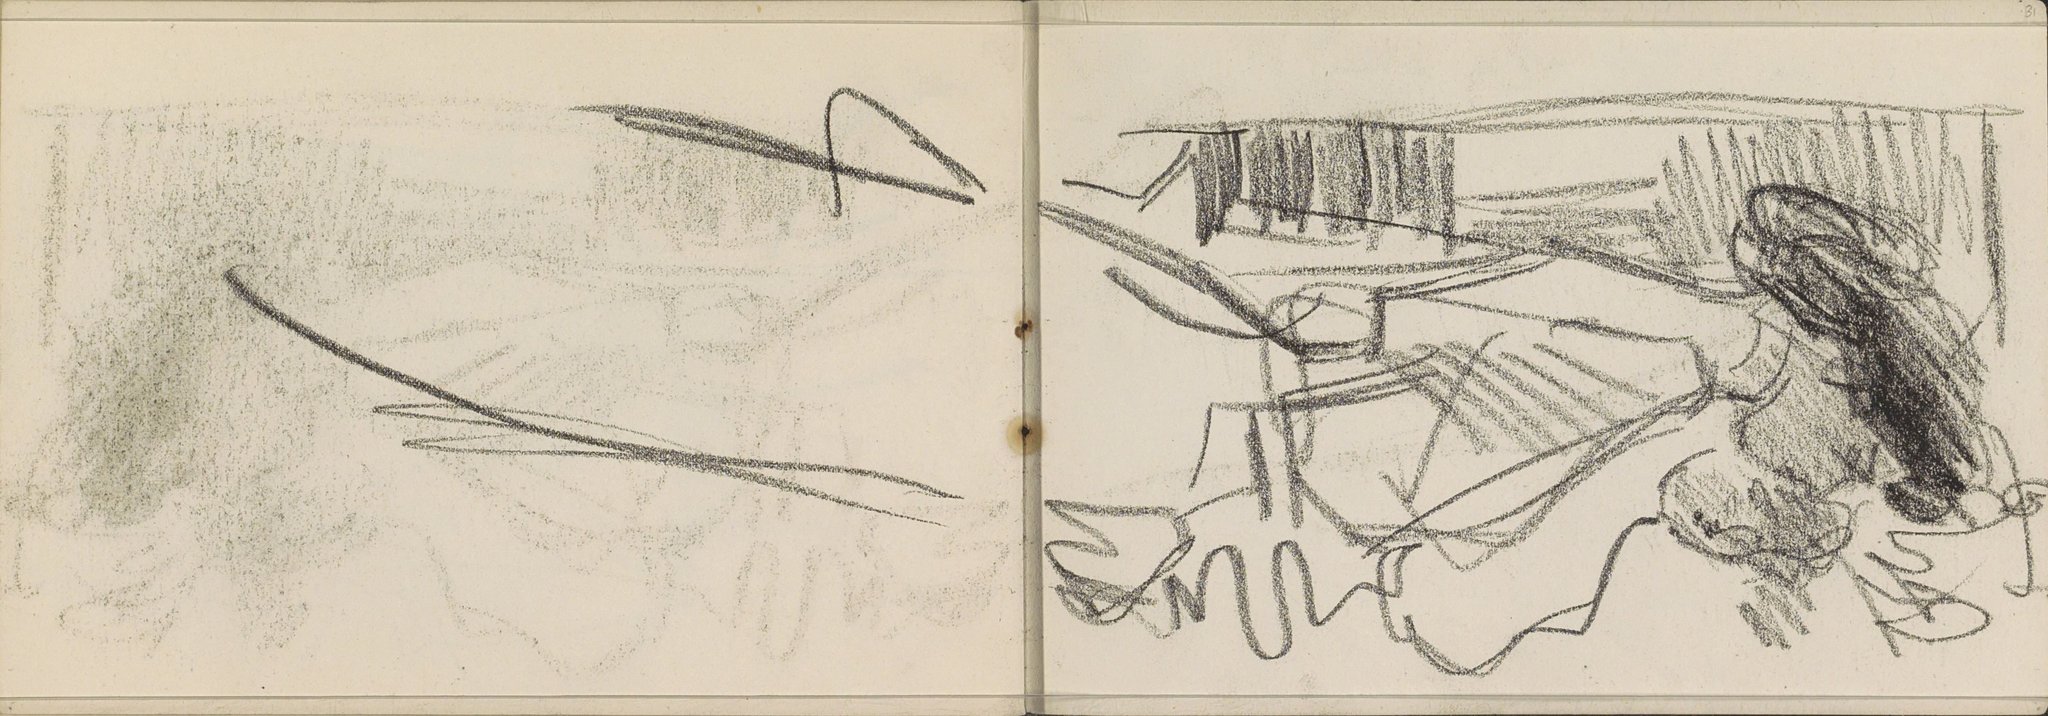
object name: sketchbook leaf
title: Twee staande vrouwen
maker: isaac israels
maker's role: draughtsman, painter, print maker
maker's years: 1865-1934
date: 1875-1934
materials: chalk, paper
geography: the hague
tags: adult woman (+ standing)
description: Pagina 30 en pagina 31 uit schetsboek XLII met 32 pagina's.